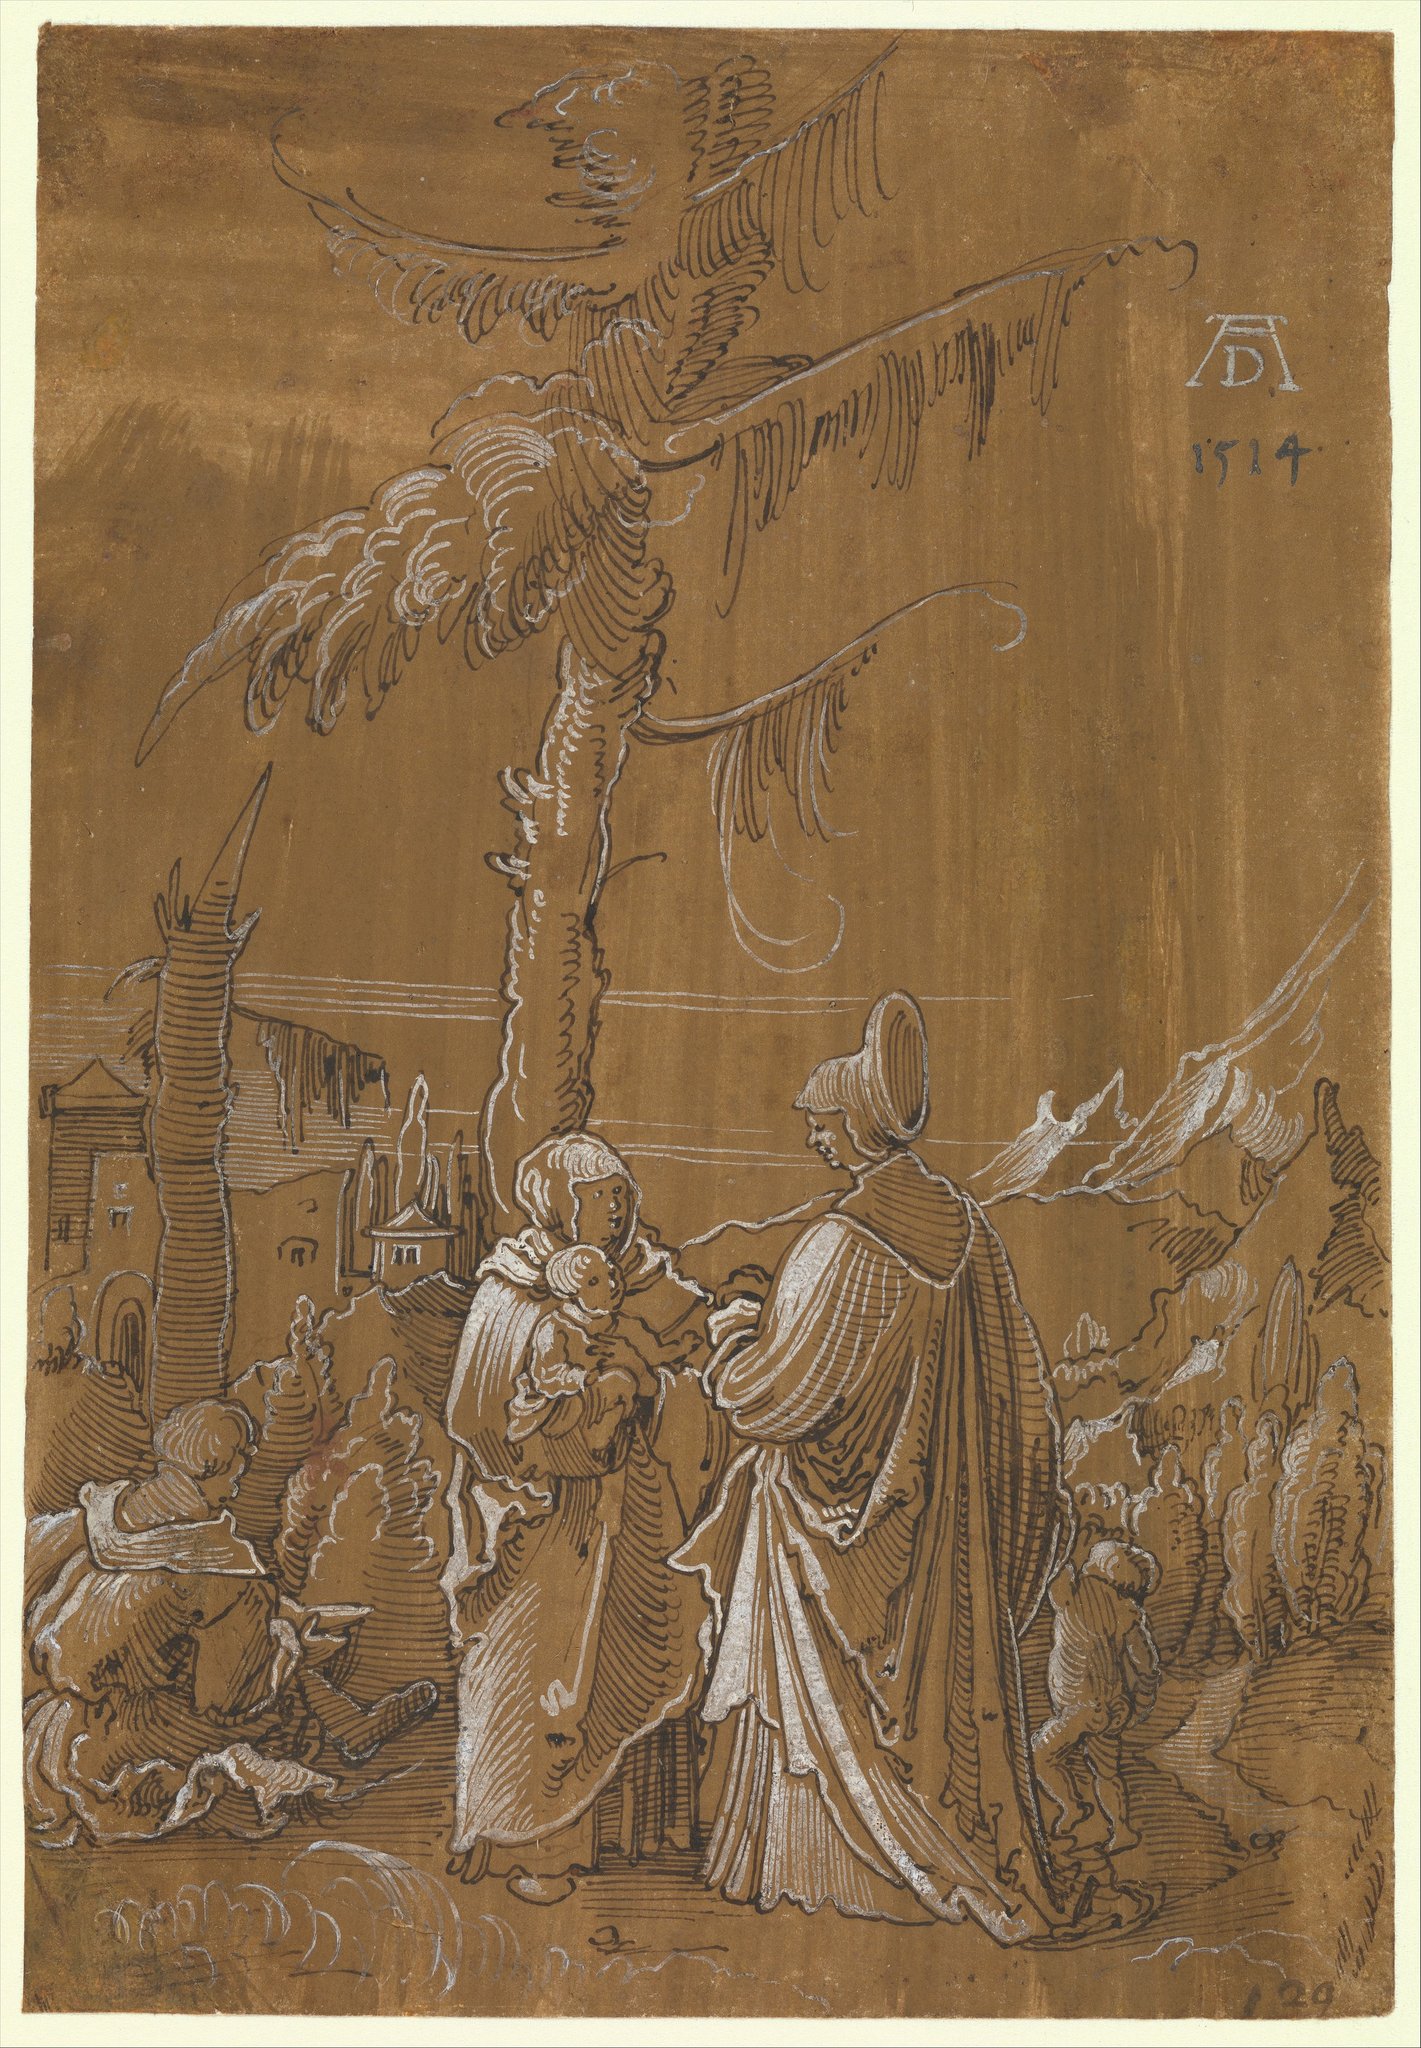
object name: drawing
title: The Holy Family with Saint Elizabeth and the Infant Saint John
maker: albrecht altdorfer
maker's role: artist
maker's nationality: german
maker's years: 1480-1538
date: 1513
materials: ink, paper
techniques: brush, highlighting, pen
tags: holy family,saint john the baptist,saints